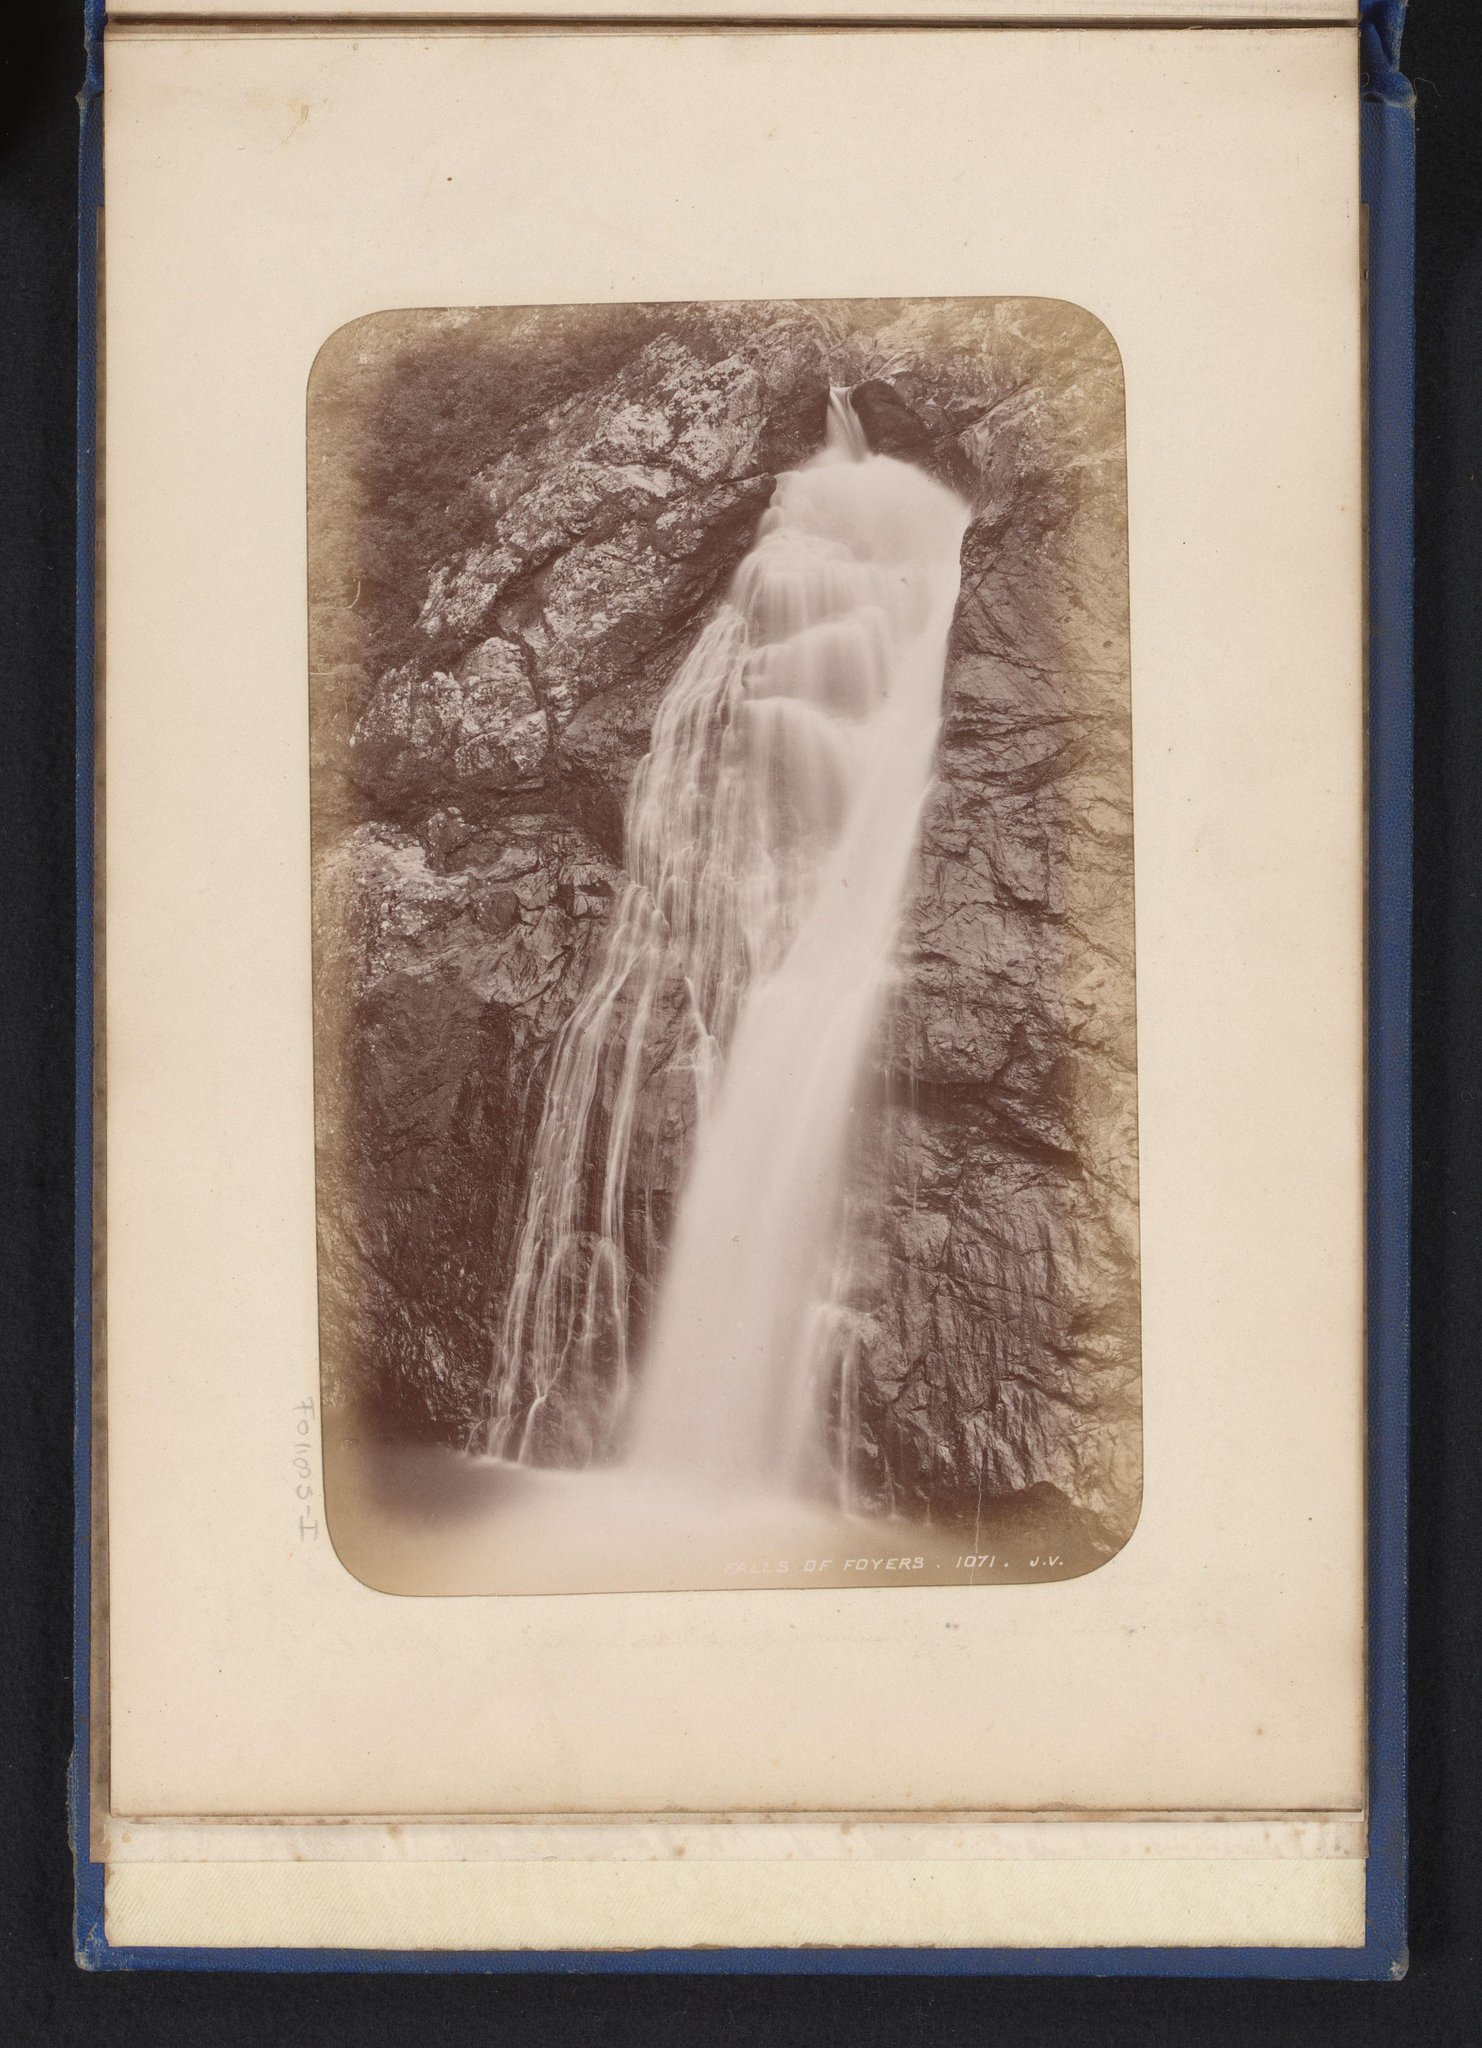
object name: album leaf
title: Waterval Falls of Foyers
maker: james valentine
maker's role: fotograaf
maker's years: 1815-1880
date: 1865-1875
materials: photographic support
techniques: albumen print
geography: loch ness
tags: waterfall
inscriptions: inscription: ‘Falls of Foyers, 1071, J.V.’